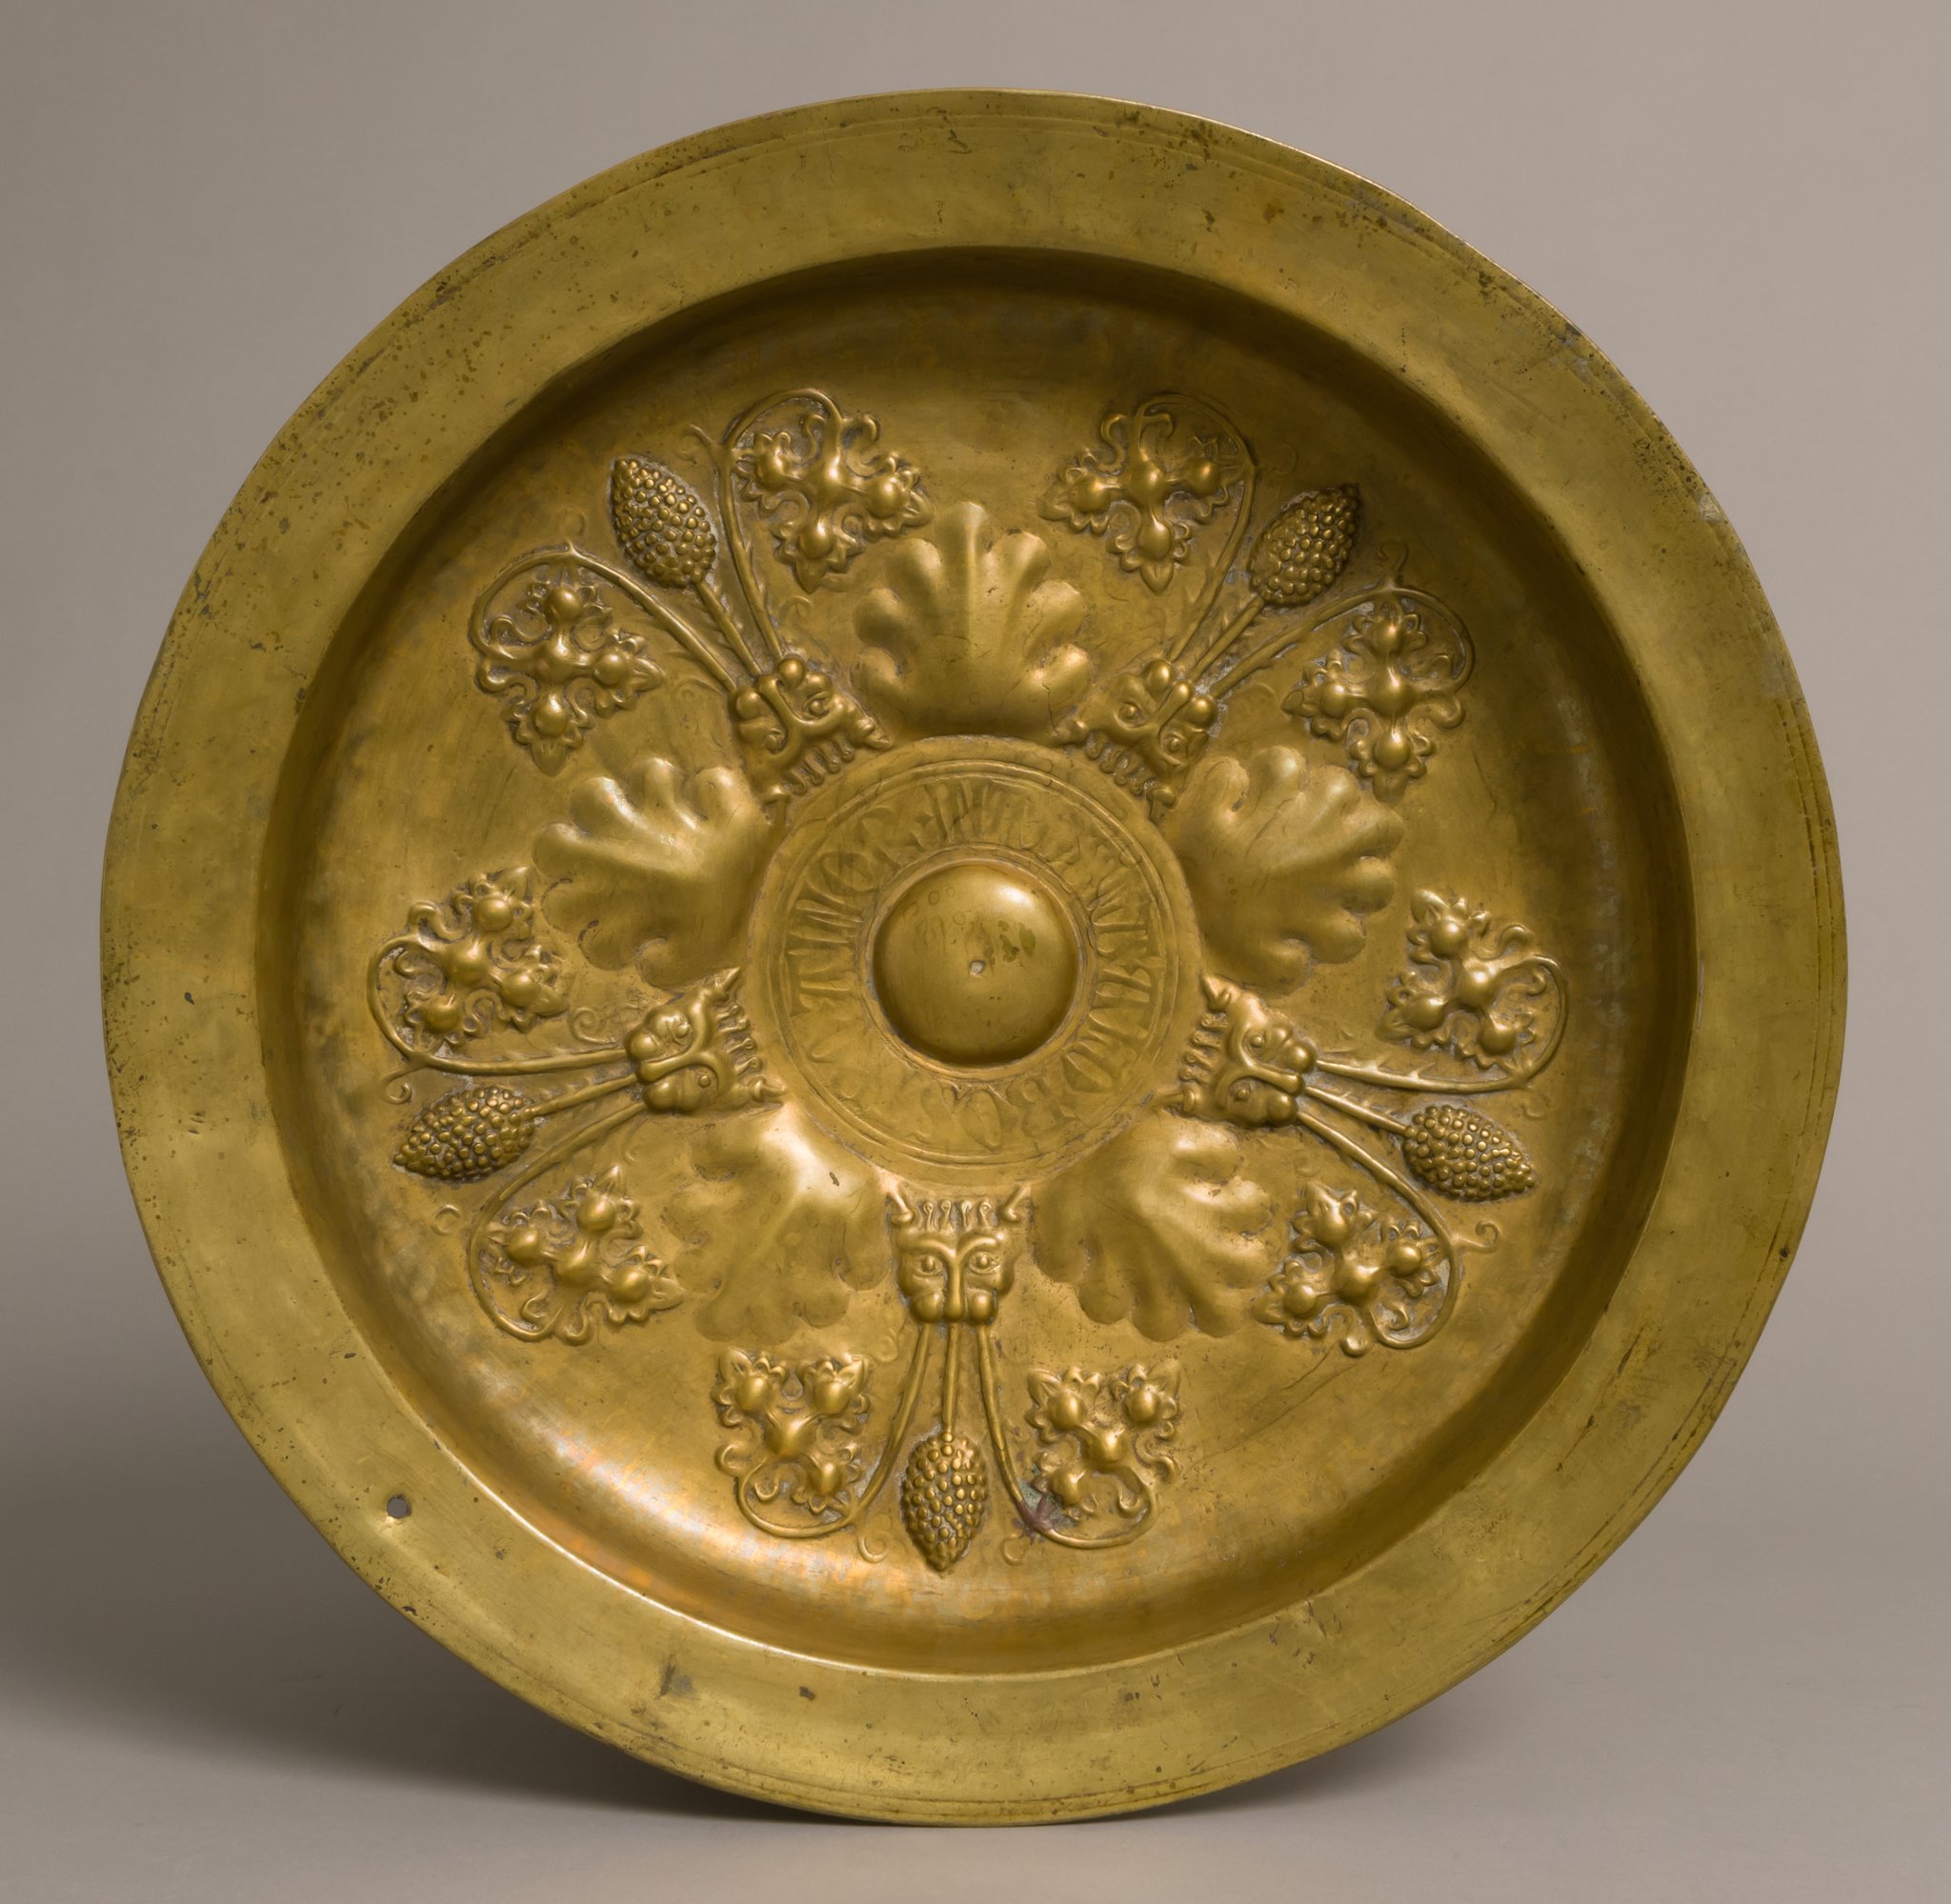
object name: plate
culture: german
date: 1467-1500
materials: brass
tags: leaves